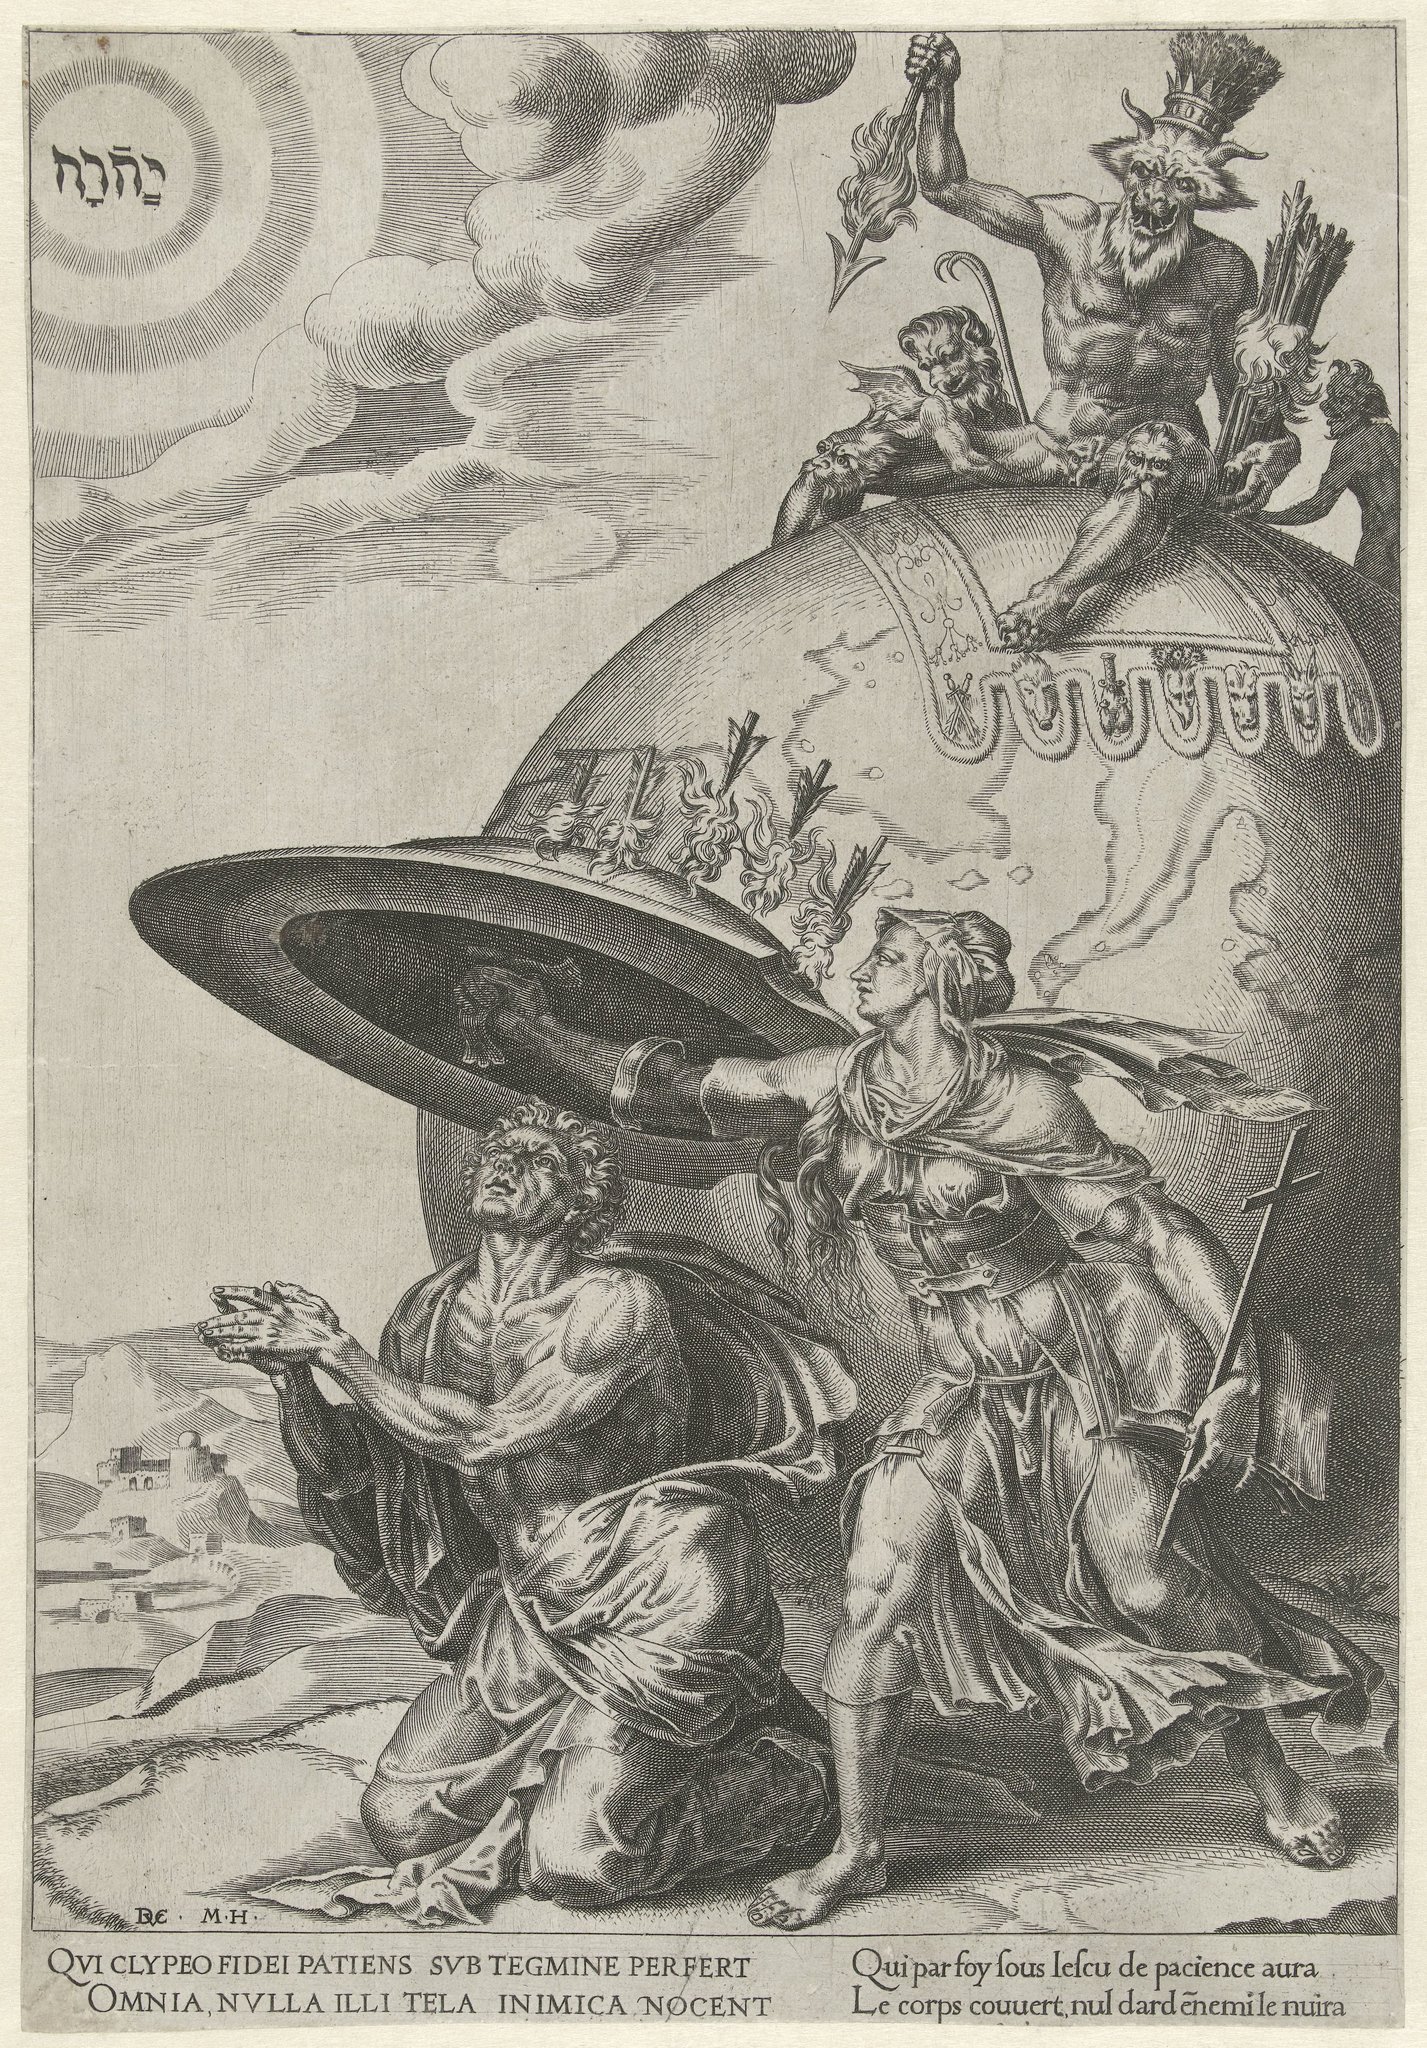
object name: print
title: Allegorieën op het geloof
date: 1557-1561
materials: paper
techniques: engraving, etching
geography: haarlem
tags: protective weapons: shield, faith, 'fides'; 'fede', 'fede catholica', 'fede christiana', 'fede christiana catholica' (ripa) ~ one of the three theological virtues, casting weapons: spear, devil(s) and demons: satan, globe, (group of) the seven deadly sins (symbolized), human being, man in general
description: Satan werpt vanaf een grote wereldbol vurige pijlen naar de knielende mens. Hij draagt een kroon van pauwenveren als een symbool voor hoogmoed en zit op een tapijt waarop de zeven hoofdzonden zijn aangebracht. Voor de wereldbol zit de geknielde mens, die naar boven kijkt, waar in de wolken het tetragram, symbool van God, verschijnt. Hij wordt tegen de pijlen van de duivel beschermd door een groot schild, dat de personificatie van het Geloof met haar rechterhand boven zijn hoofd houdt. In haar andere hand de Heilige Schrift en een Kruis. De prent is deel van een tweeluik met allegorieën op het geloof en heeft een Latijns en Frans onderschrift.